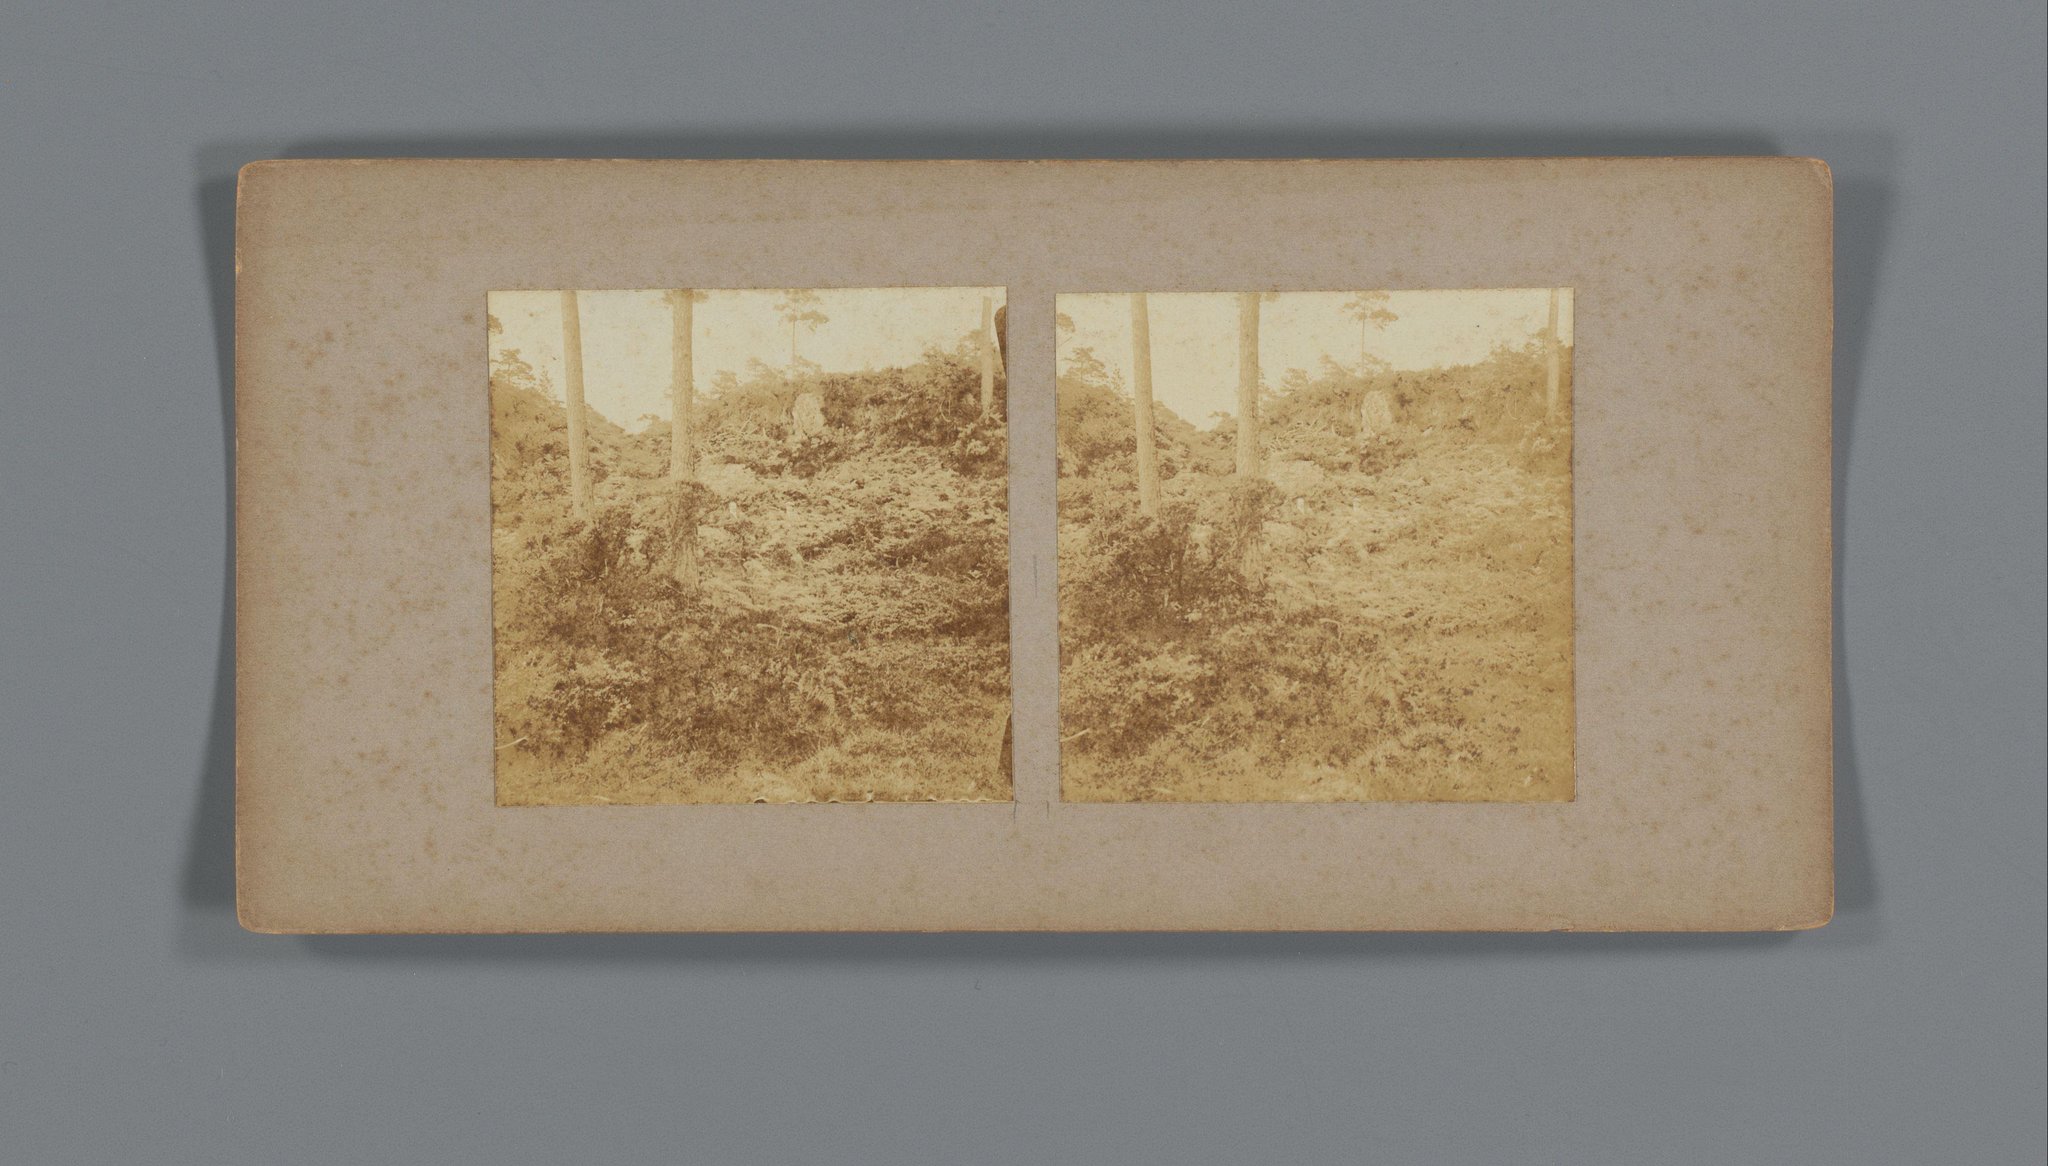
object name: stereograph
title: Bos nabij Larvik, Noorwegen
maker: Anonymous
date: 1882-1890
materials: cardboard, photographic support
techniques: collodion silver print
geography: larvik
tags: forest, wood